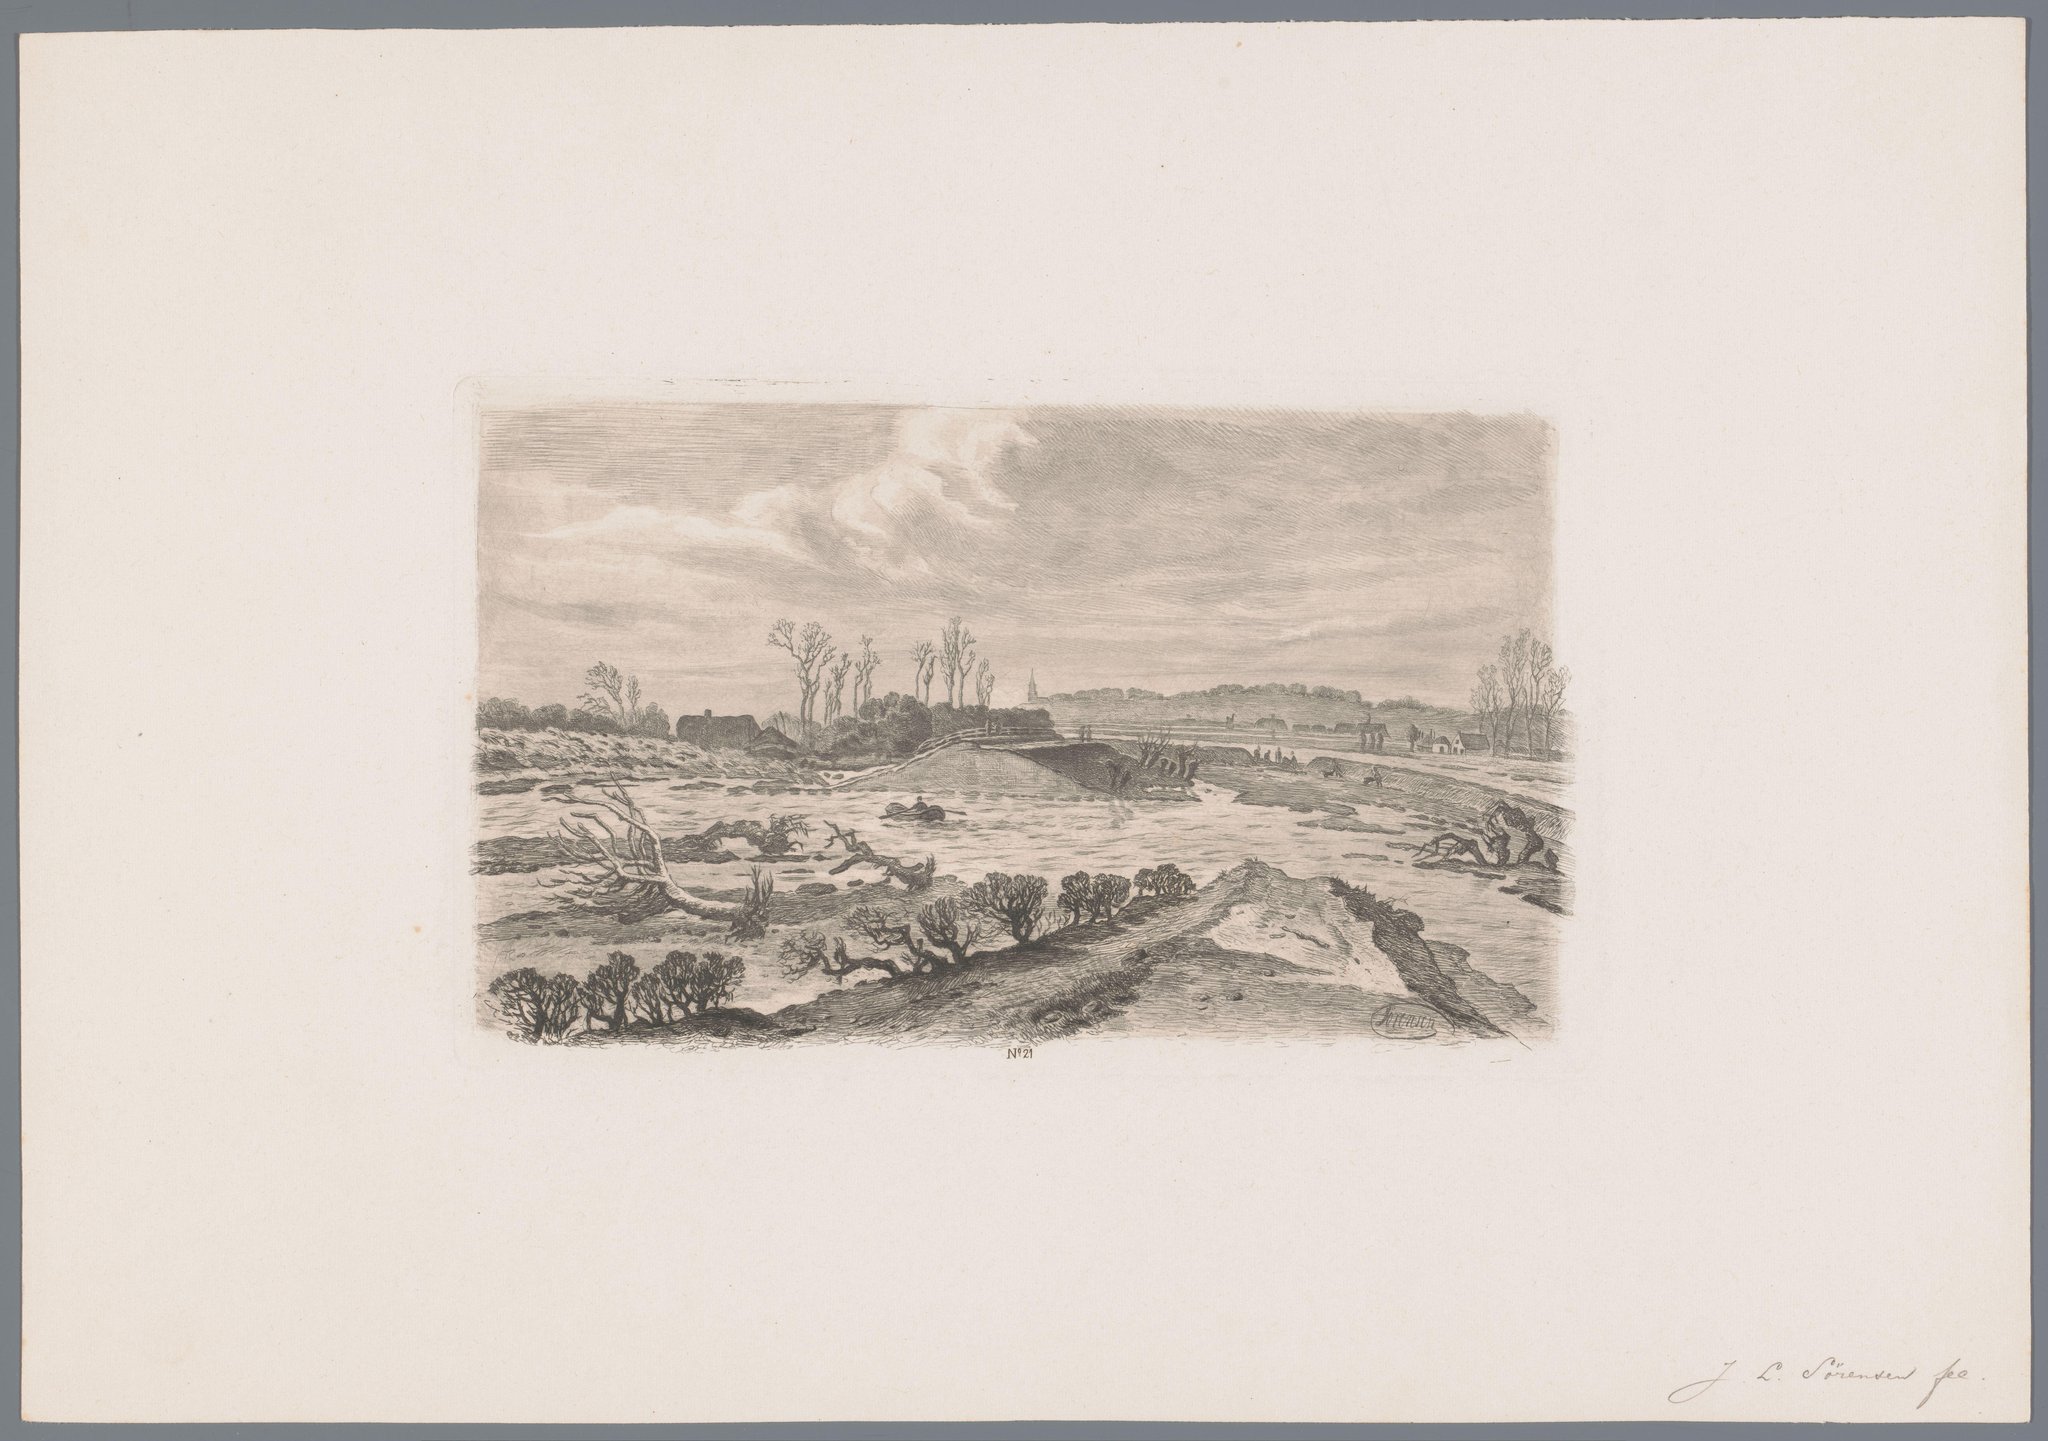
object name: print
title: Doorbraak van den Neder-Betuwschen Bandijk te Ingen, 23 Maart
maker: jacobus sörensen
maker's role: painter, print maker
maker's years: 1812-1857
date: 1855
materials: paper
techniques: etching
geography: netherlands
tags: dike-break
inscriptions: collector's mark: Lugt 2228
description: Doorbraak van de Neder-Betuwse Bandijk bij het dorp Ingen, 23 maart 1855. Onderdeel van de reeks van 24 prenten over de watersnood van maart 1855, door leden van het genootschap Arti et Amicitiae. Uitgave ten behoeve van de slachtoffers van de watersnood.